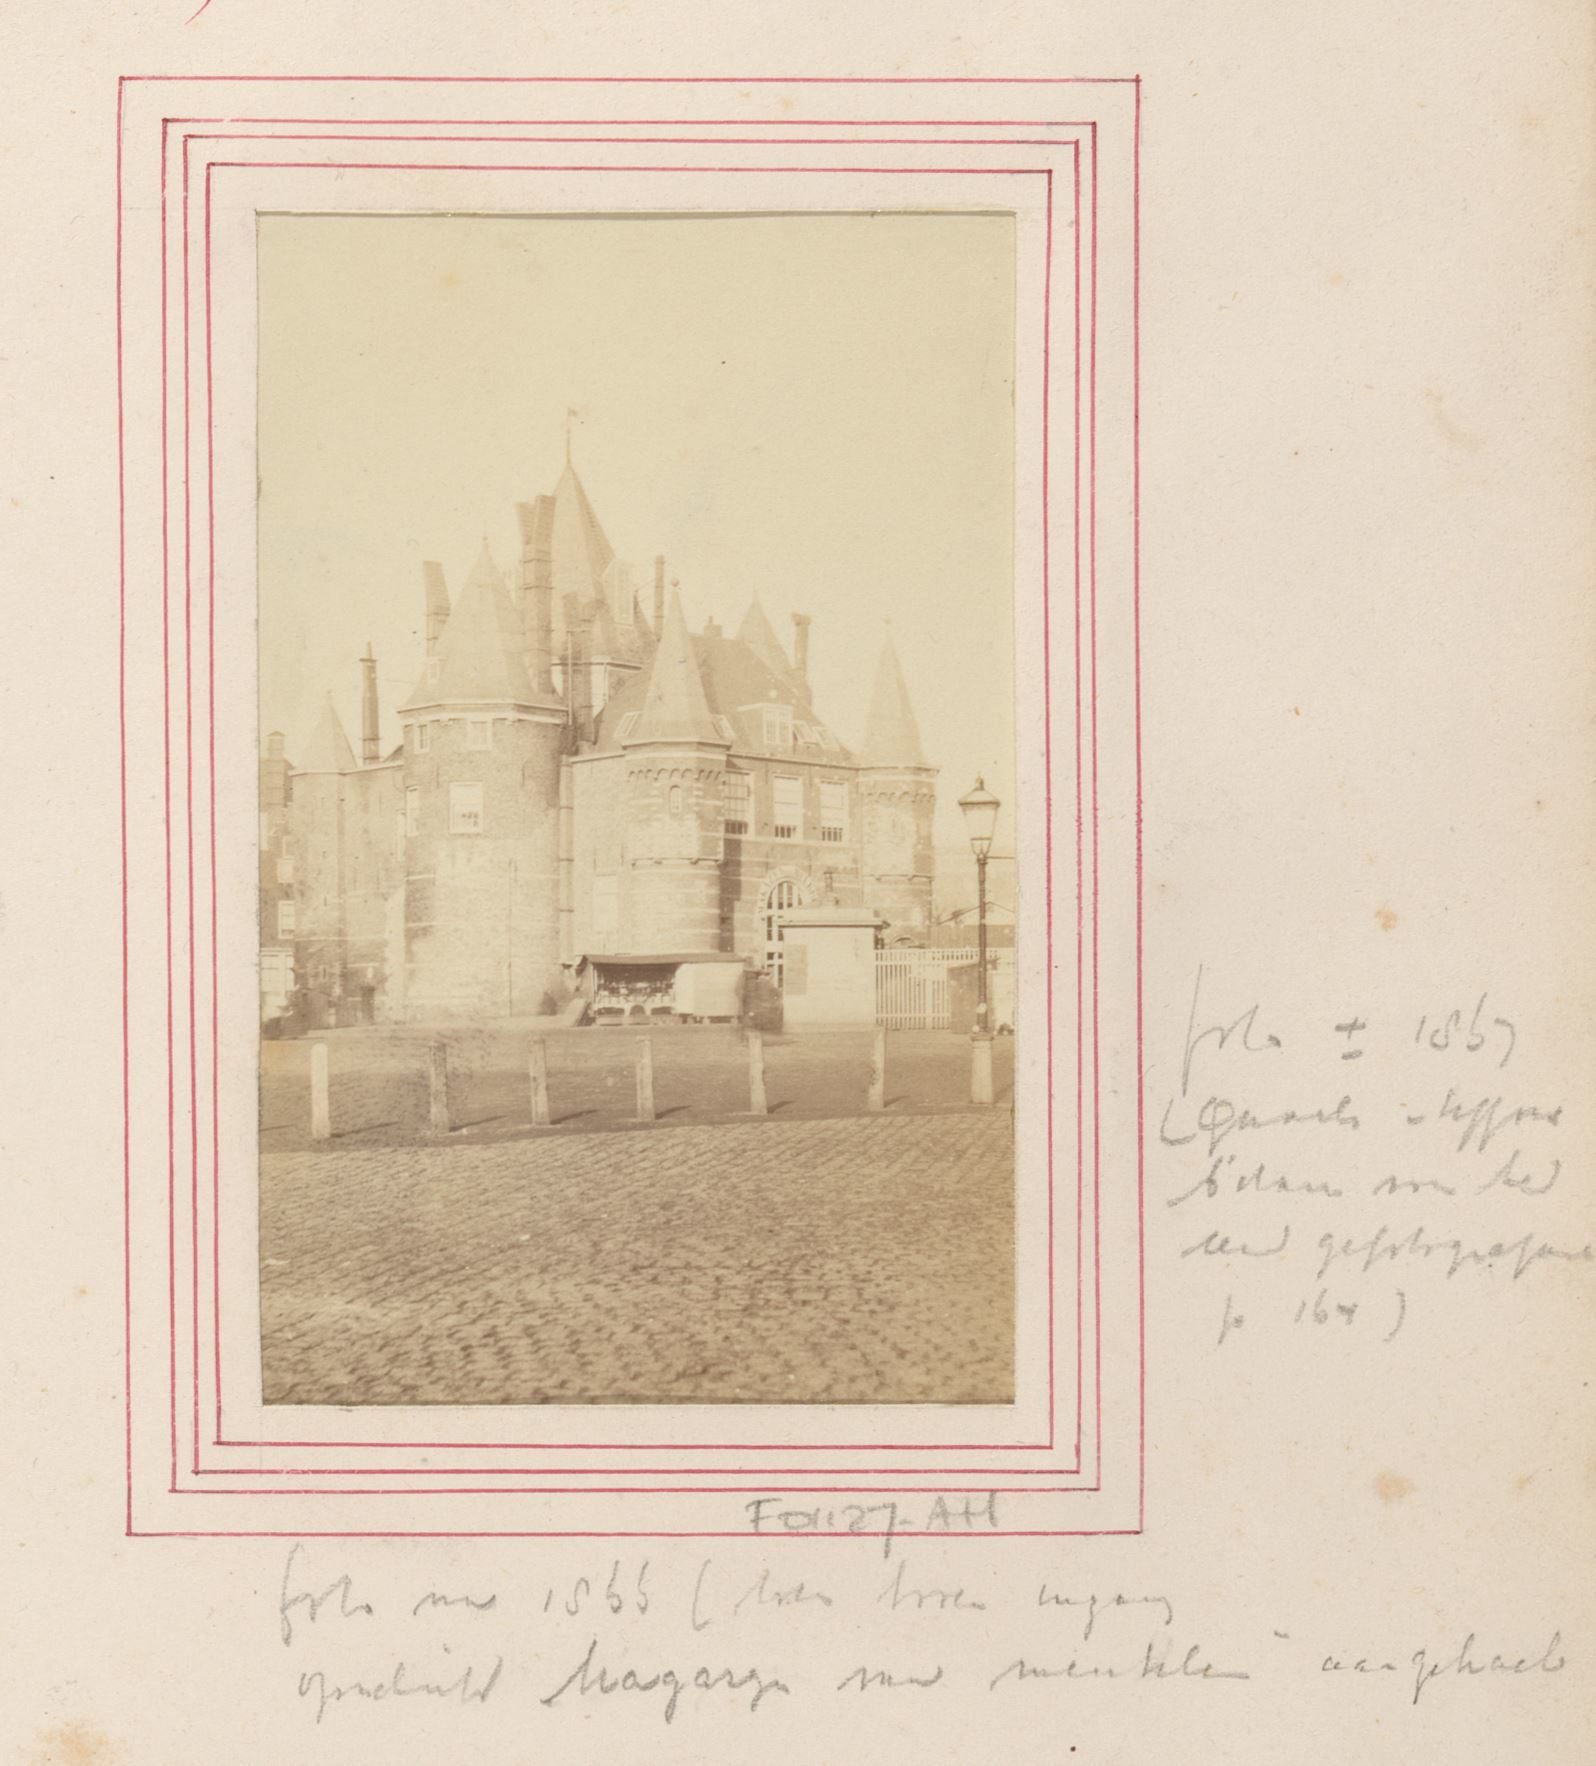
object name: photograph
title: Gezicht op het Waaggebouw aan de Nieuwmarkt in Amsterdam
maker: pieter oosterhuis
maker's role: draughtsman, print maker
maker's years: 1816-1885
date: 1867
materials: photographic support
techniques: albumen print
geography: nieuwmarkt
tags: weigh-house, square, place, circus, etc. (+ city(-scape) with figures, staffage)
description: Onderdeel van Album met foto's en litho's van bezienswaardigheden in Noord- en Zuid-Hollandse steden, schilderijen en klederdrachten.